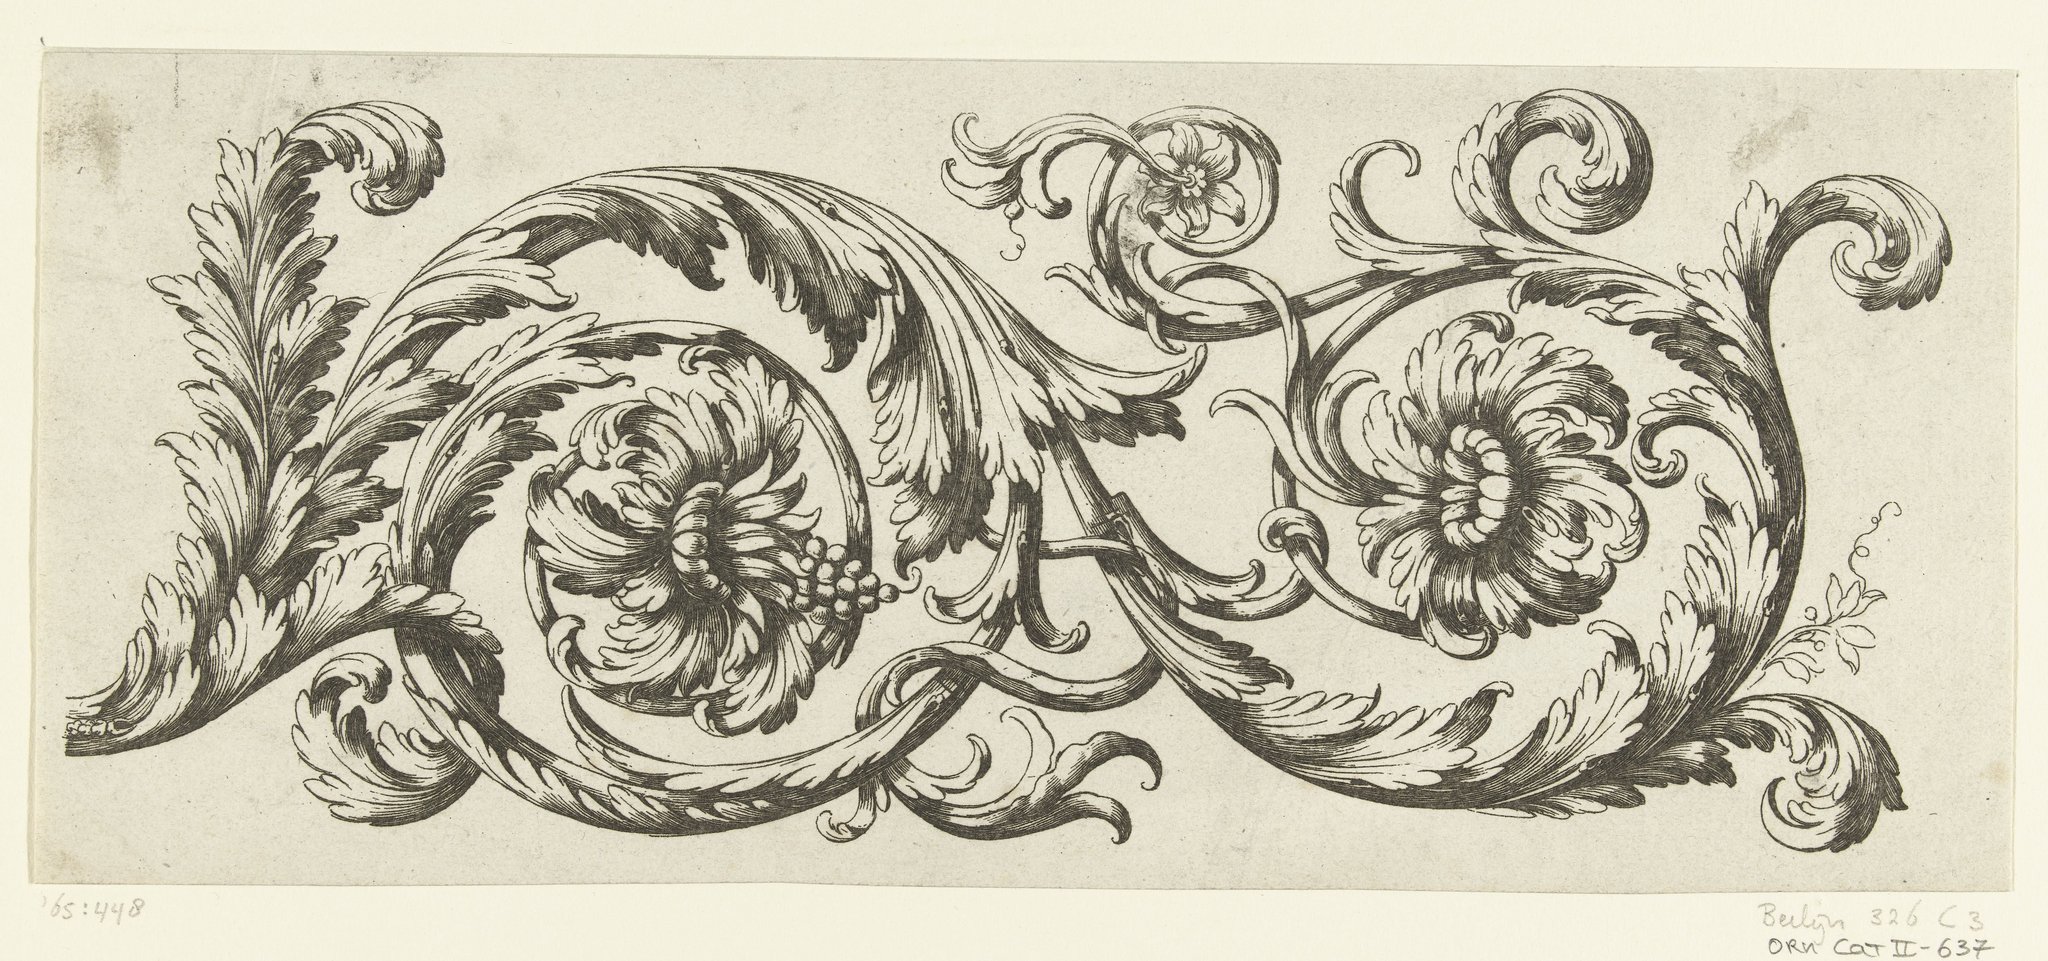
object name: print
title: Frises Propres pour les Peintres, Sculpteurs, Orfèvres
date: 1710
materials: paper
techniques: etching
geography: paris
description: Blad 3 uit serie van 6 bladen, linksonder genummerd 1-6, links- en rechtsboven staan oudere nummers. Derde editie.